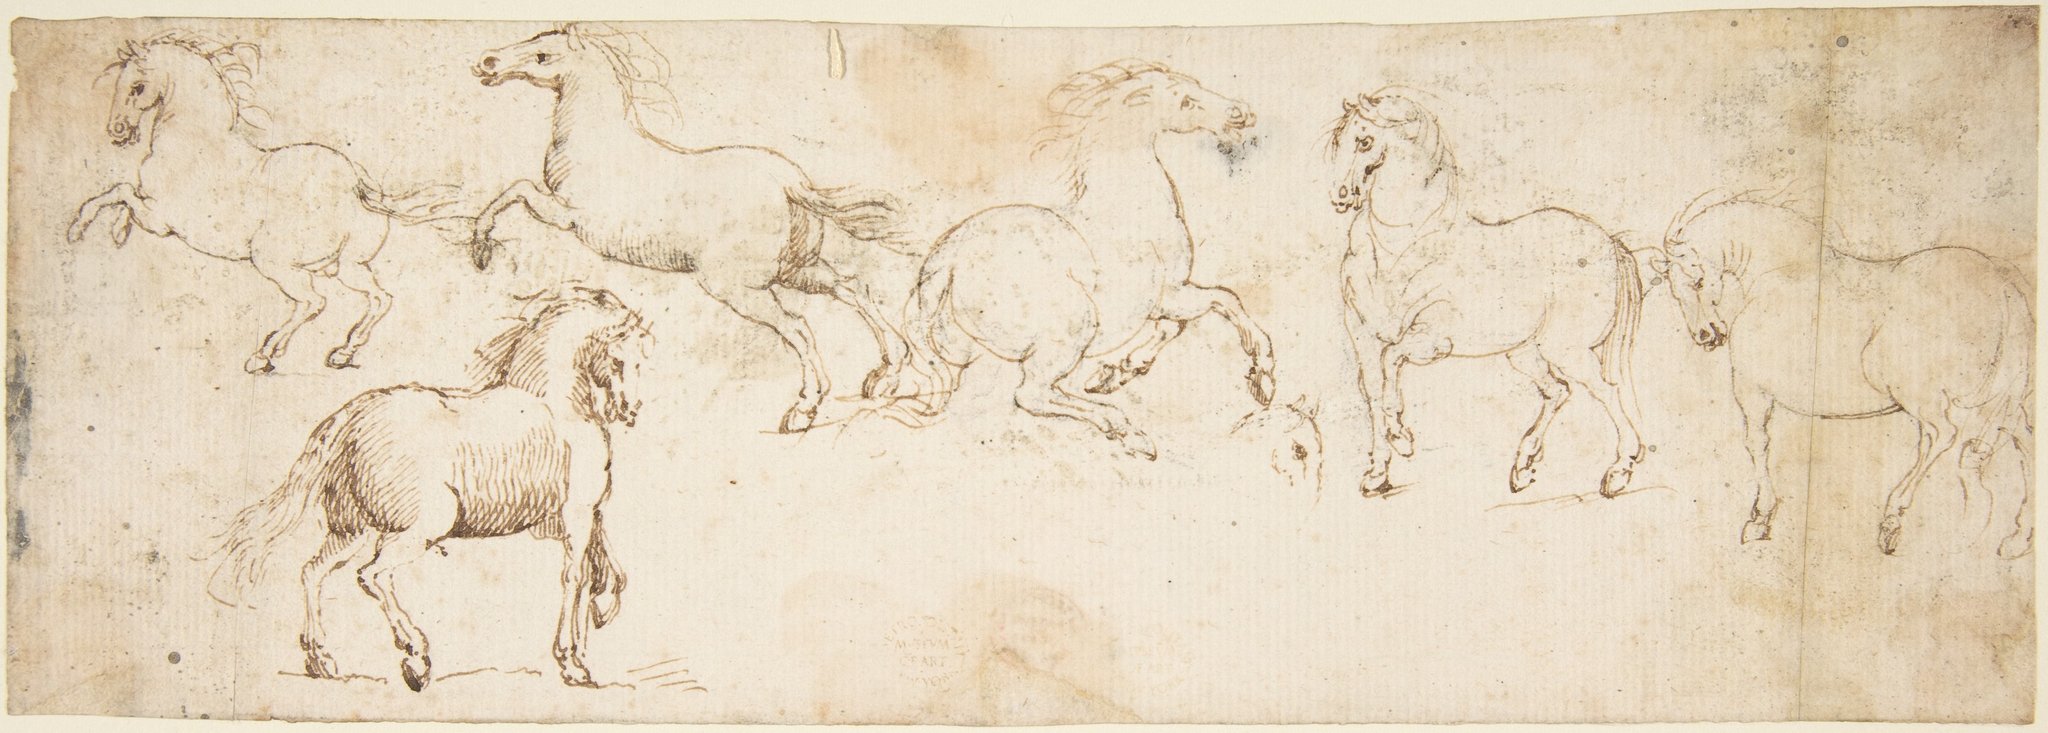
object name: drawing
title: Horses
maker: francesco allegrini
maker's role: artist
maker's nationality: italian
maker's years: 1615-1679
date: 1624-1663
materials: ink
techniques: pen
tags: horses